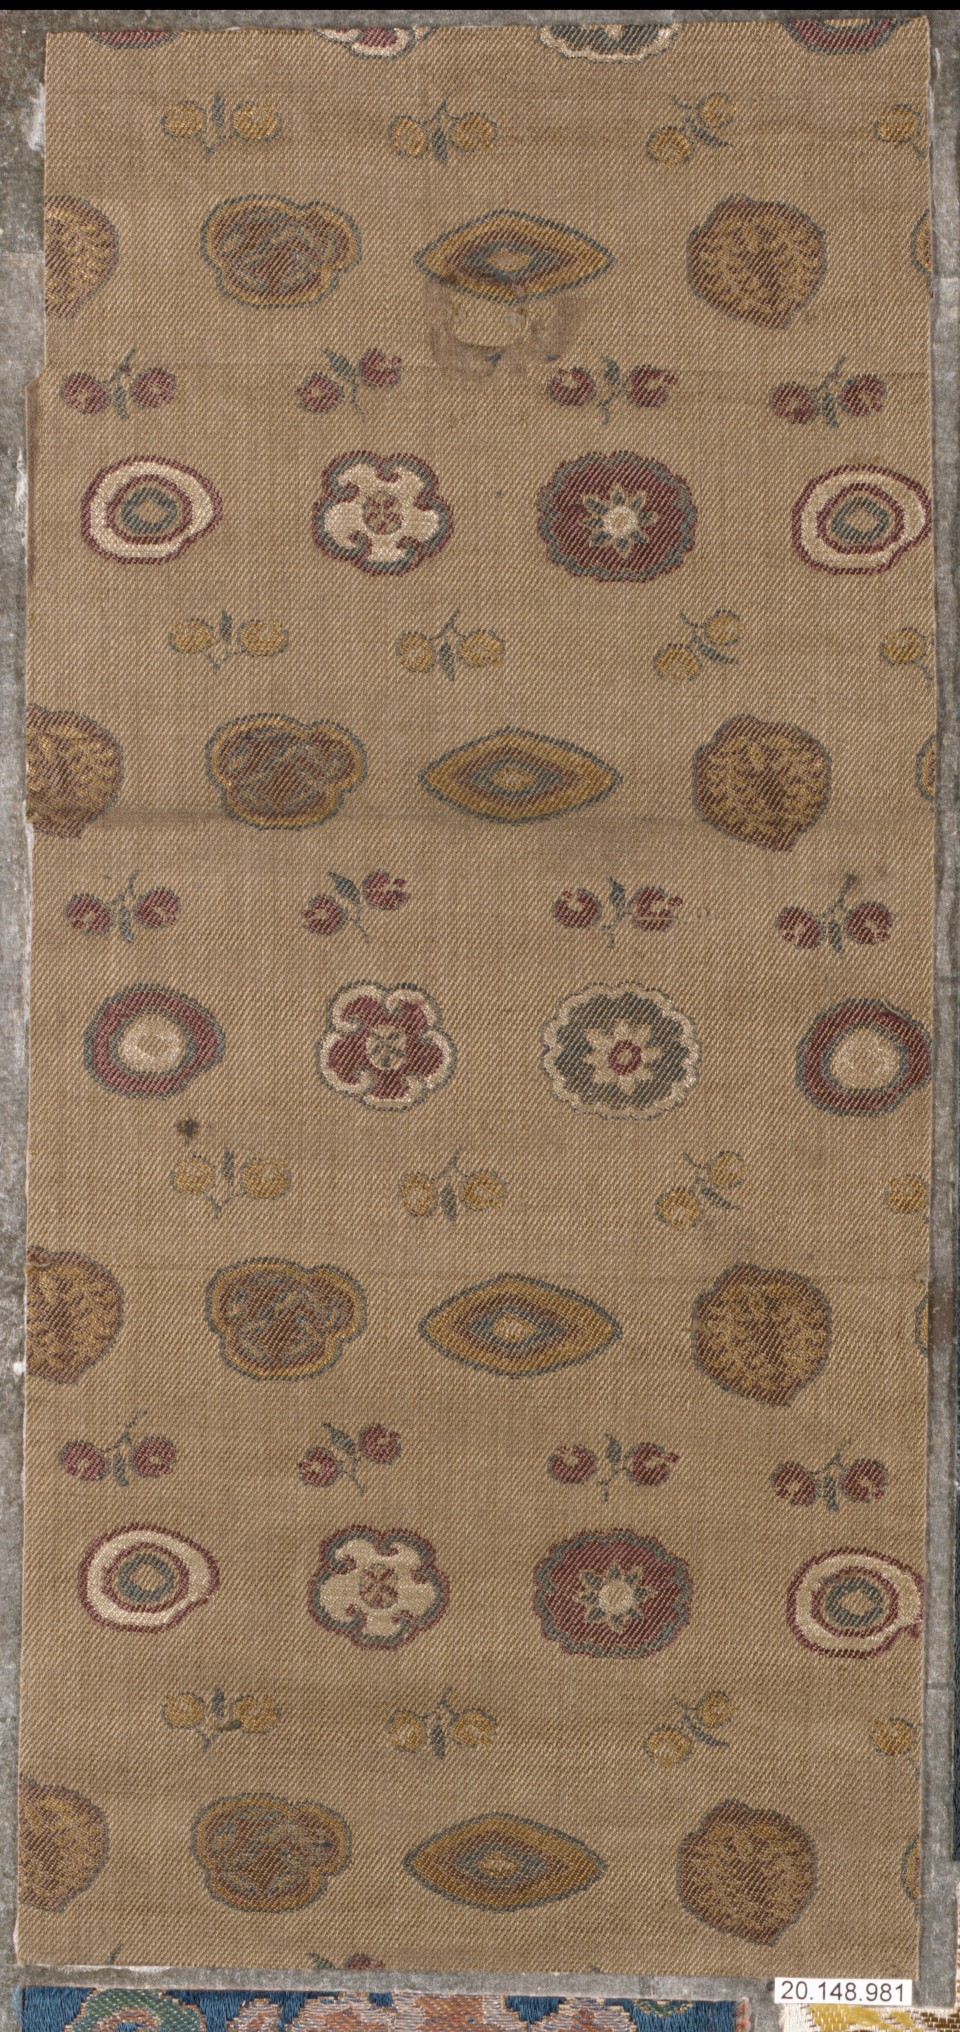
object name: piece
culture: japanese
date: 1701-1800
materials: silk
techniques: compound weave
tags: flowers